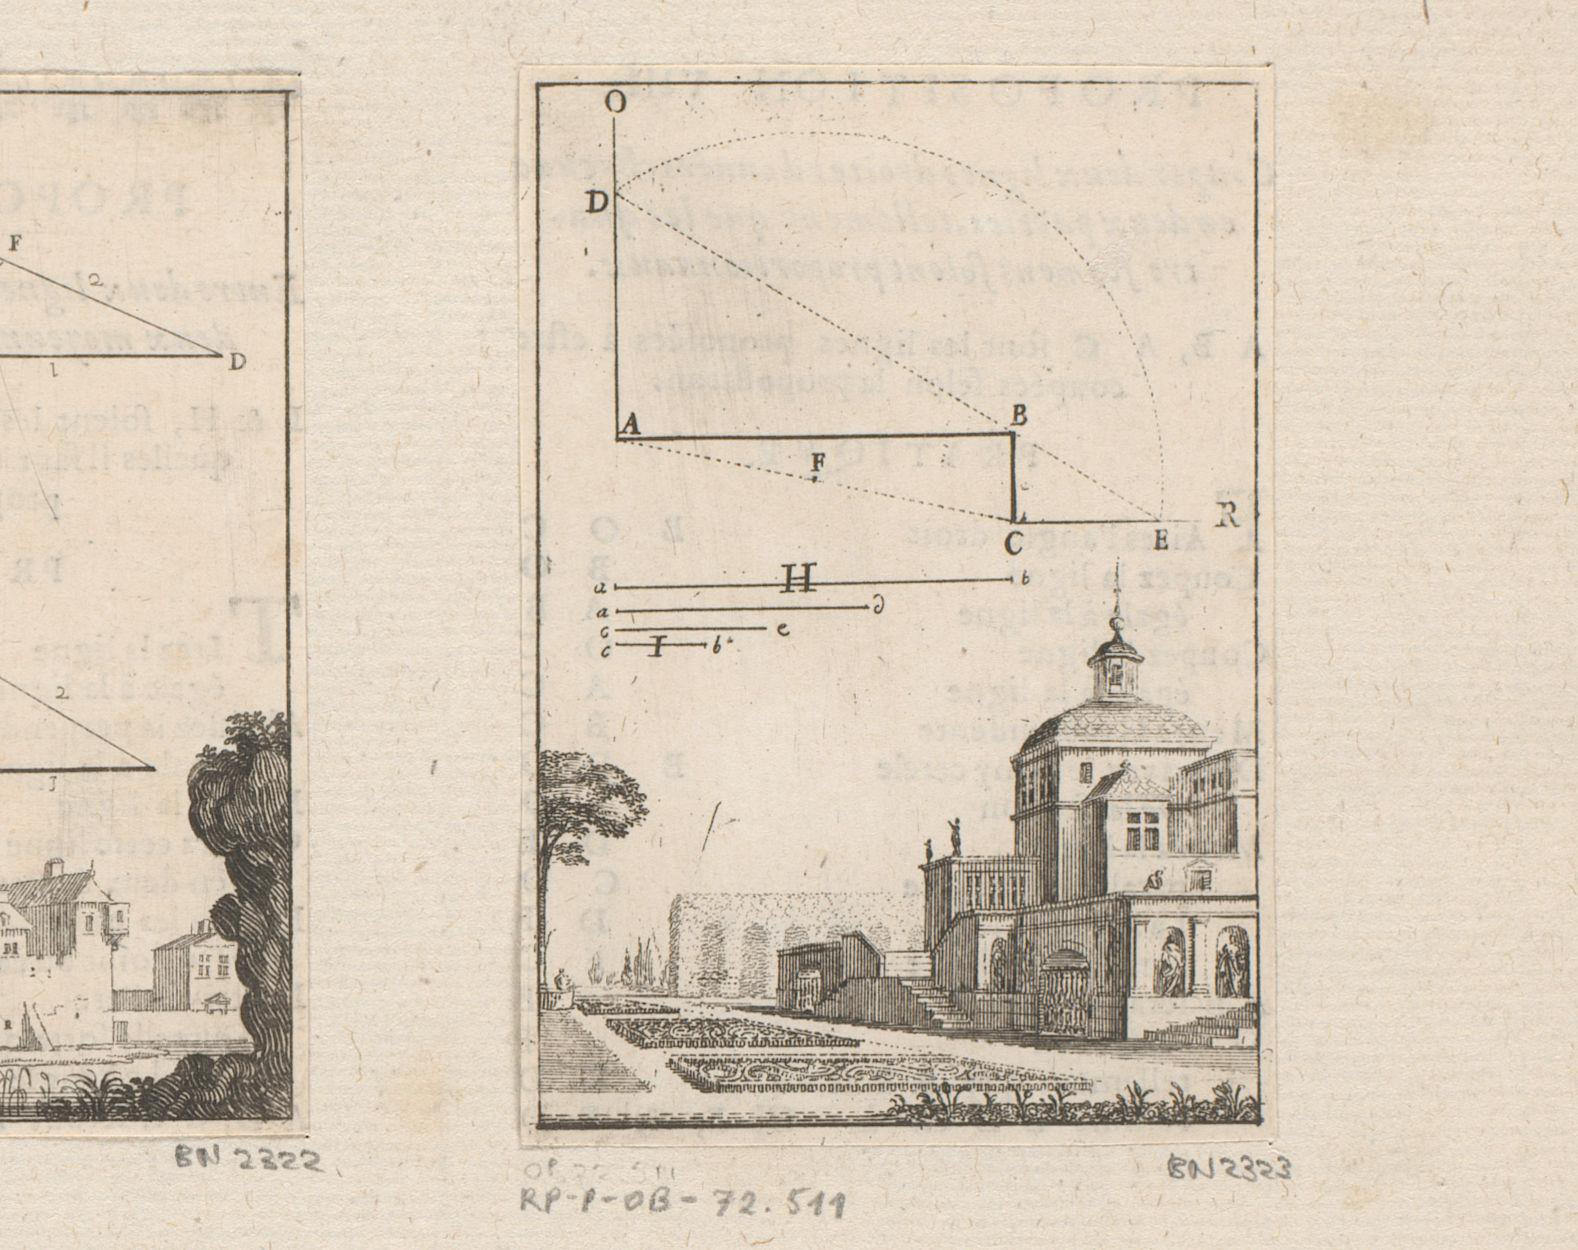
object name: book illustration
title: Verhouding tussen twee rechte gegeven lijnen met onderaan een kerk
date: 1669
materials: paper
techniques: etching, letterpress printing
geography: france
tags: church (exterior), planimetry, geometry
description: Prent uit: Pratique de la géometrie, sur le papier et sur le terrain. Avec un nouvel ordre et une méthode particulière. Parijs: Thomas Jolly, 1669.